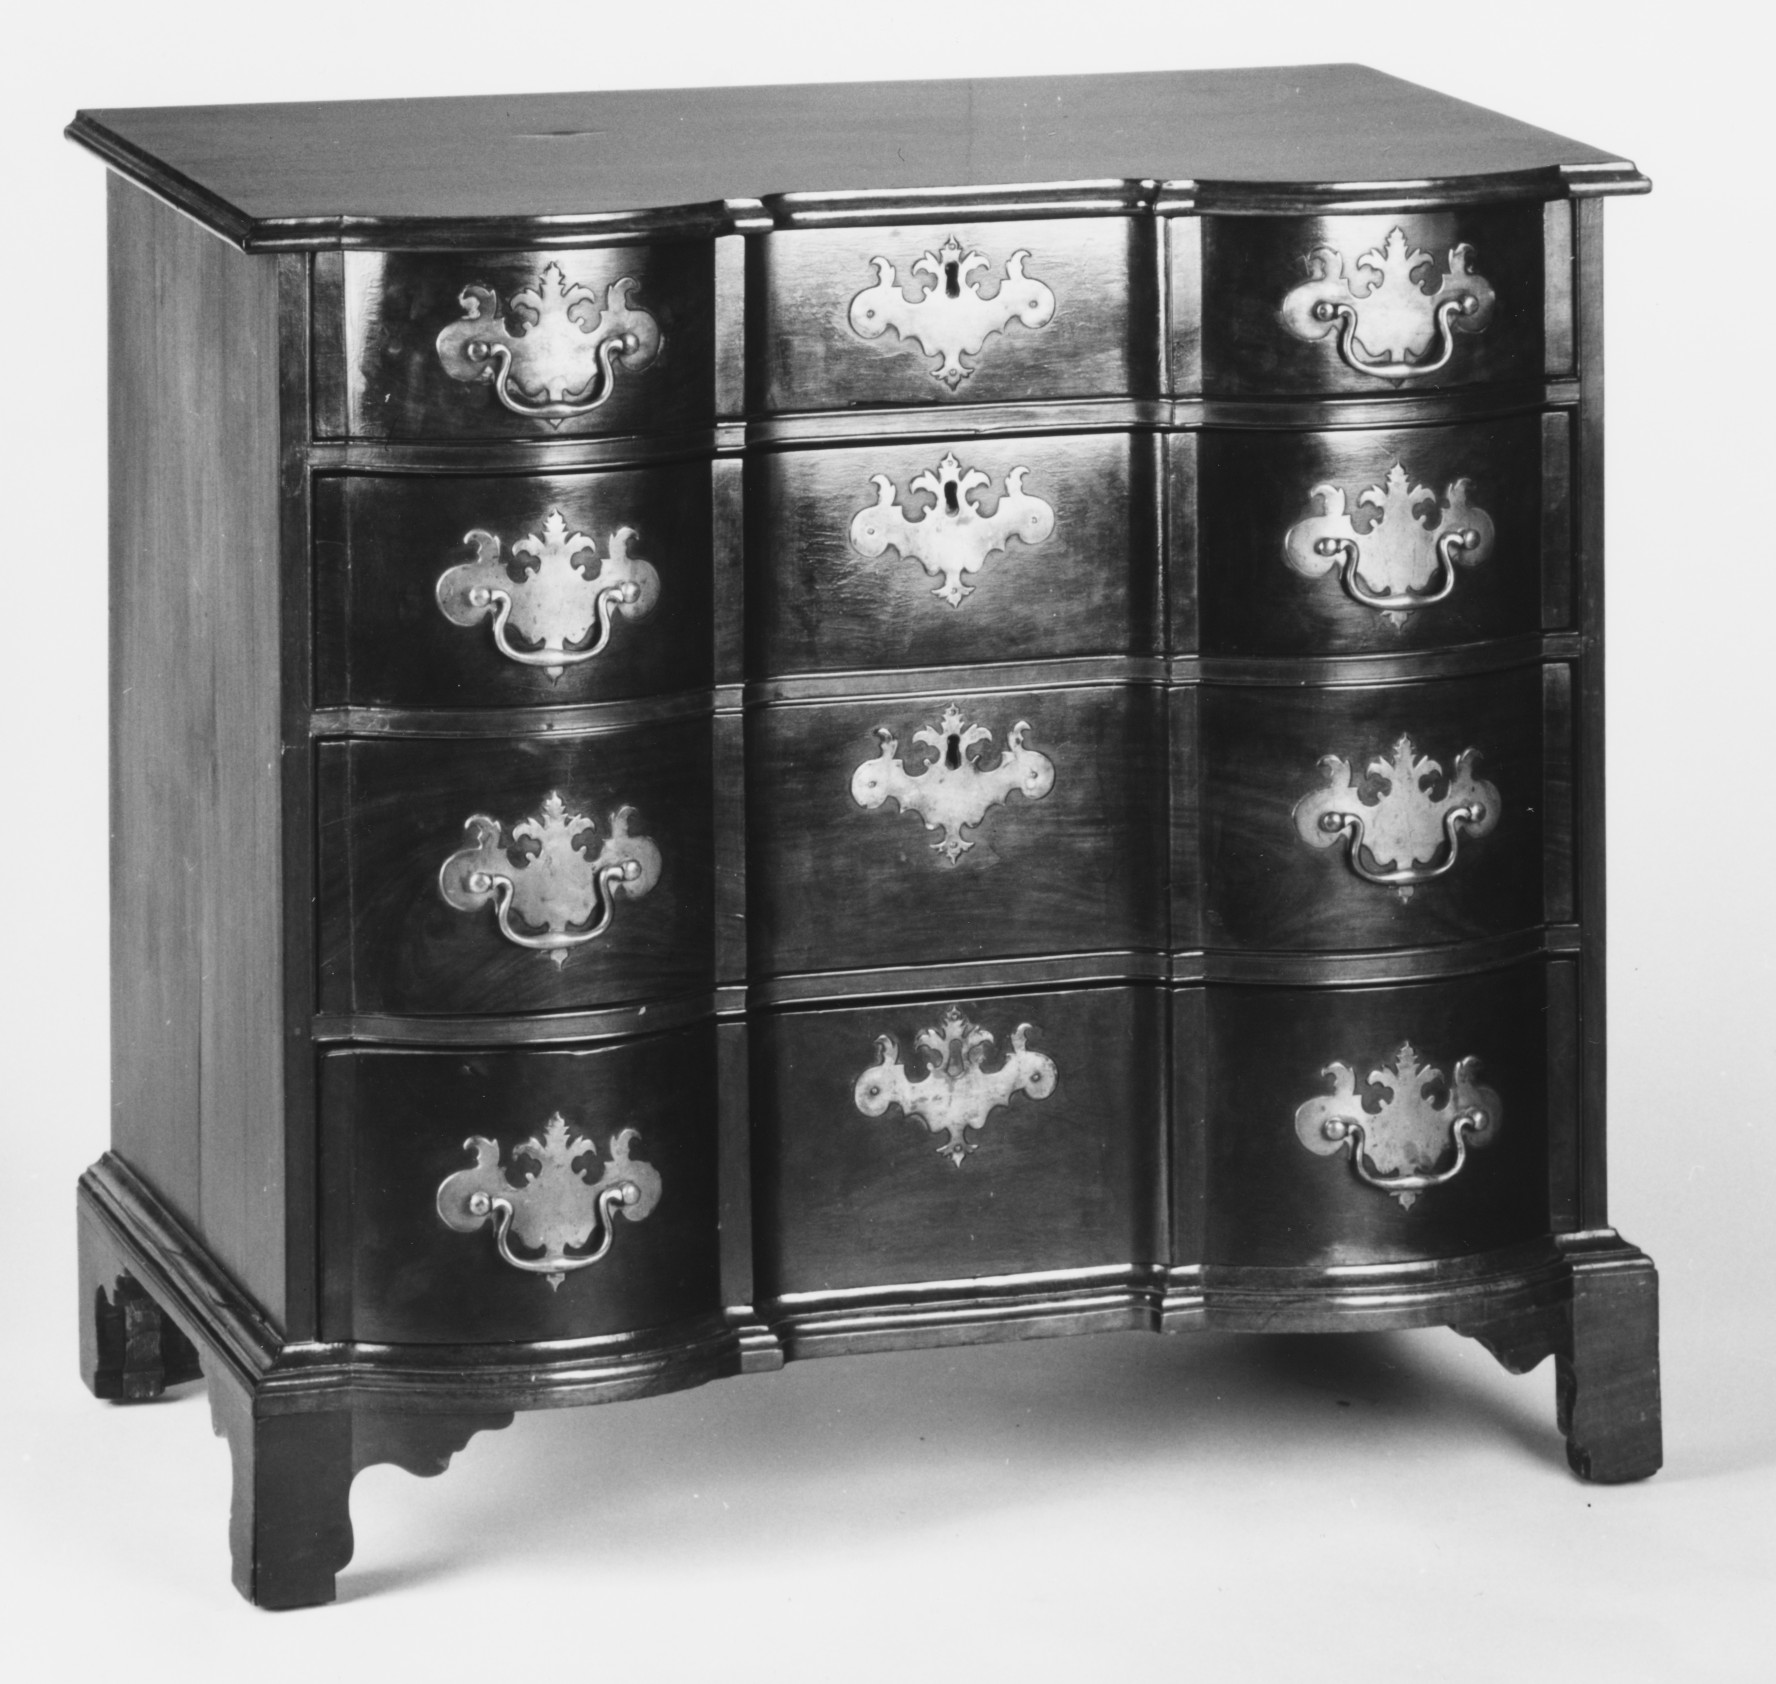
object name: chest of drawer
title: Chest of Drawers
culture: american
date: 1750-1790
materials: wood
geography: united states